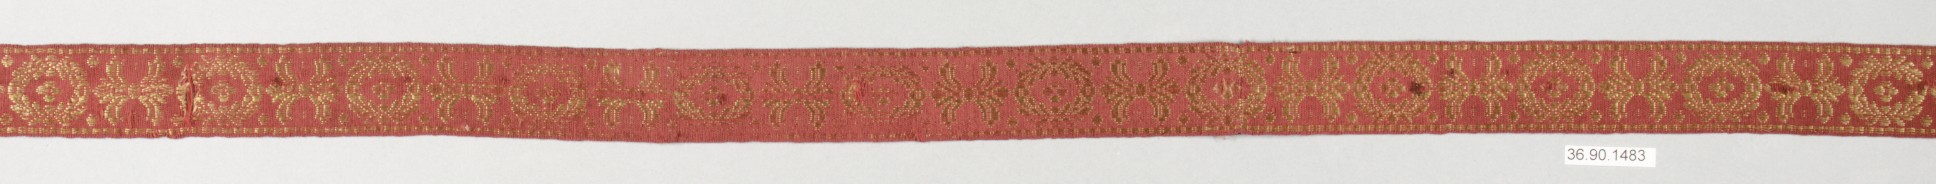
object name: ribbon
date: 1801-1900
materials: silk